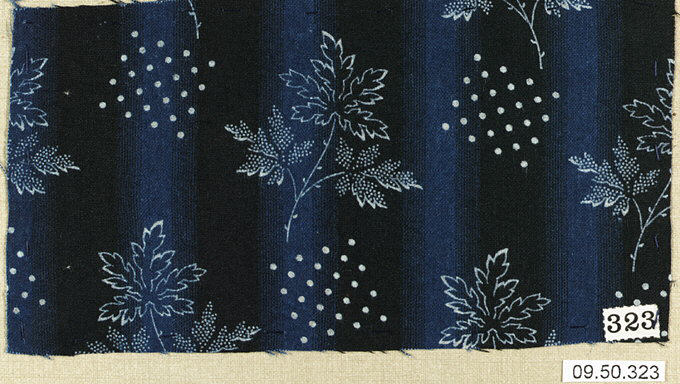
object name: piece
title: Piece (one of 116)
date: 1801-1900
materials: cotton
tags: leaves